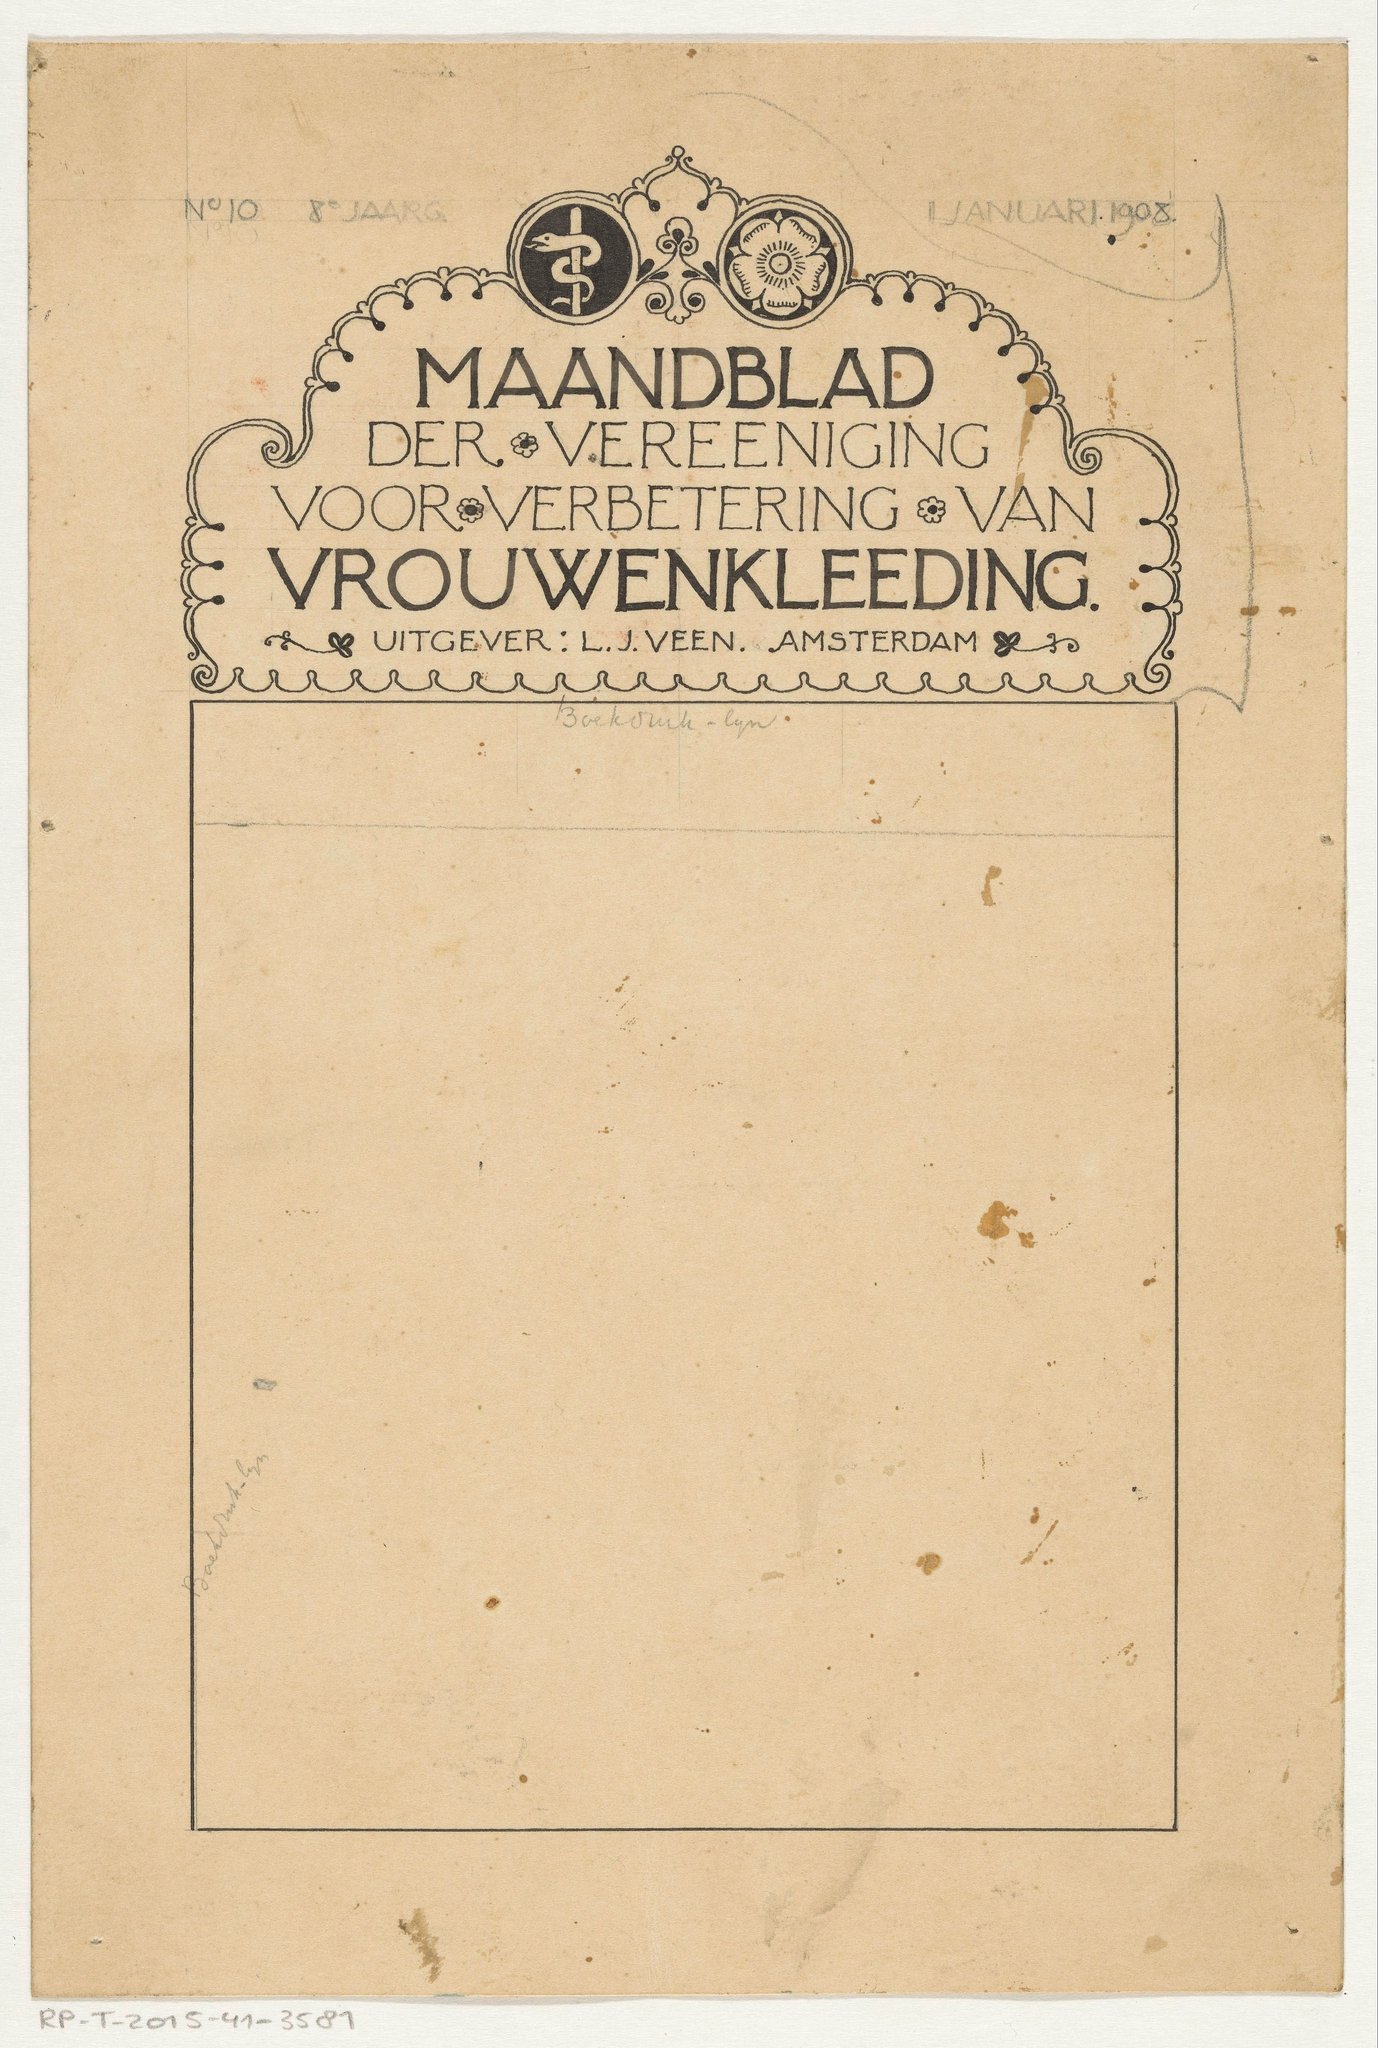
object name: design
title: Vignet van het Maandblad der Vereeniging voor verbetering van vrouwenkleeding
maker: Anonymous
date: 1901-1908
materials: cardboard, ink, pencil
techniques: pen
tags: symbol, emblem, sign ~ medicine, flowers ~ ornament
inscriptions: collector's mark: Lugt 2228a, annotation: ‘Boekdruk - lijn/ Boekdruk-lijn’, number: ‘6’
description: Ontwerp voor een vignet met de naam van het tijdschrift gevat in krullende lijnen, versierd met bloemen en twee medaillons met een bloem en esculaap. Onder het vignet een tekstkader.